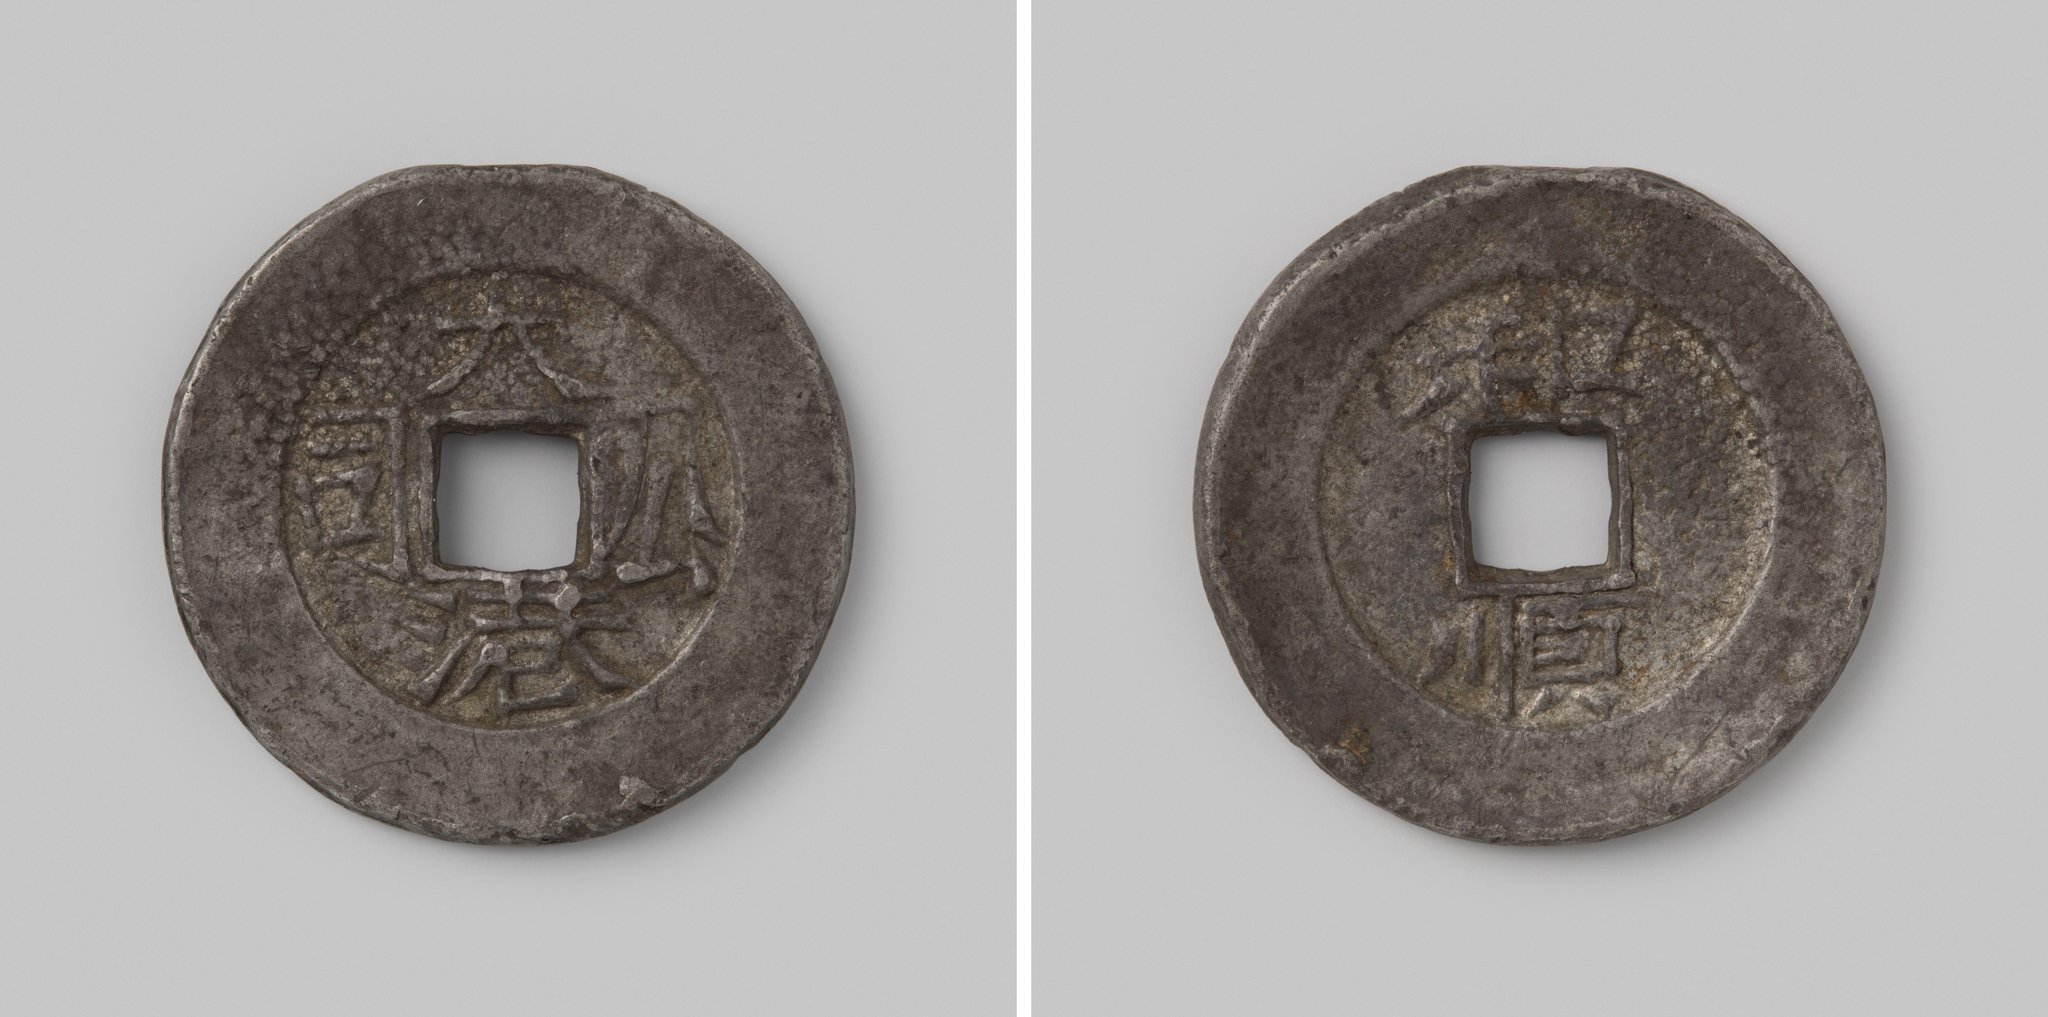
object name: coin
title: Ta-kiang mijn-kongsi in Montrado, Borneo, 5 tsiën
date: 1650-1700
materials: tin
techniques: casting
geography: djambi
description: Tinnen munt. Particuliere munt.Voorzijde: vier chinese karakters. Keerzijde:twee Chinese karakters. In het midden vierkant gat.